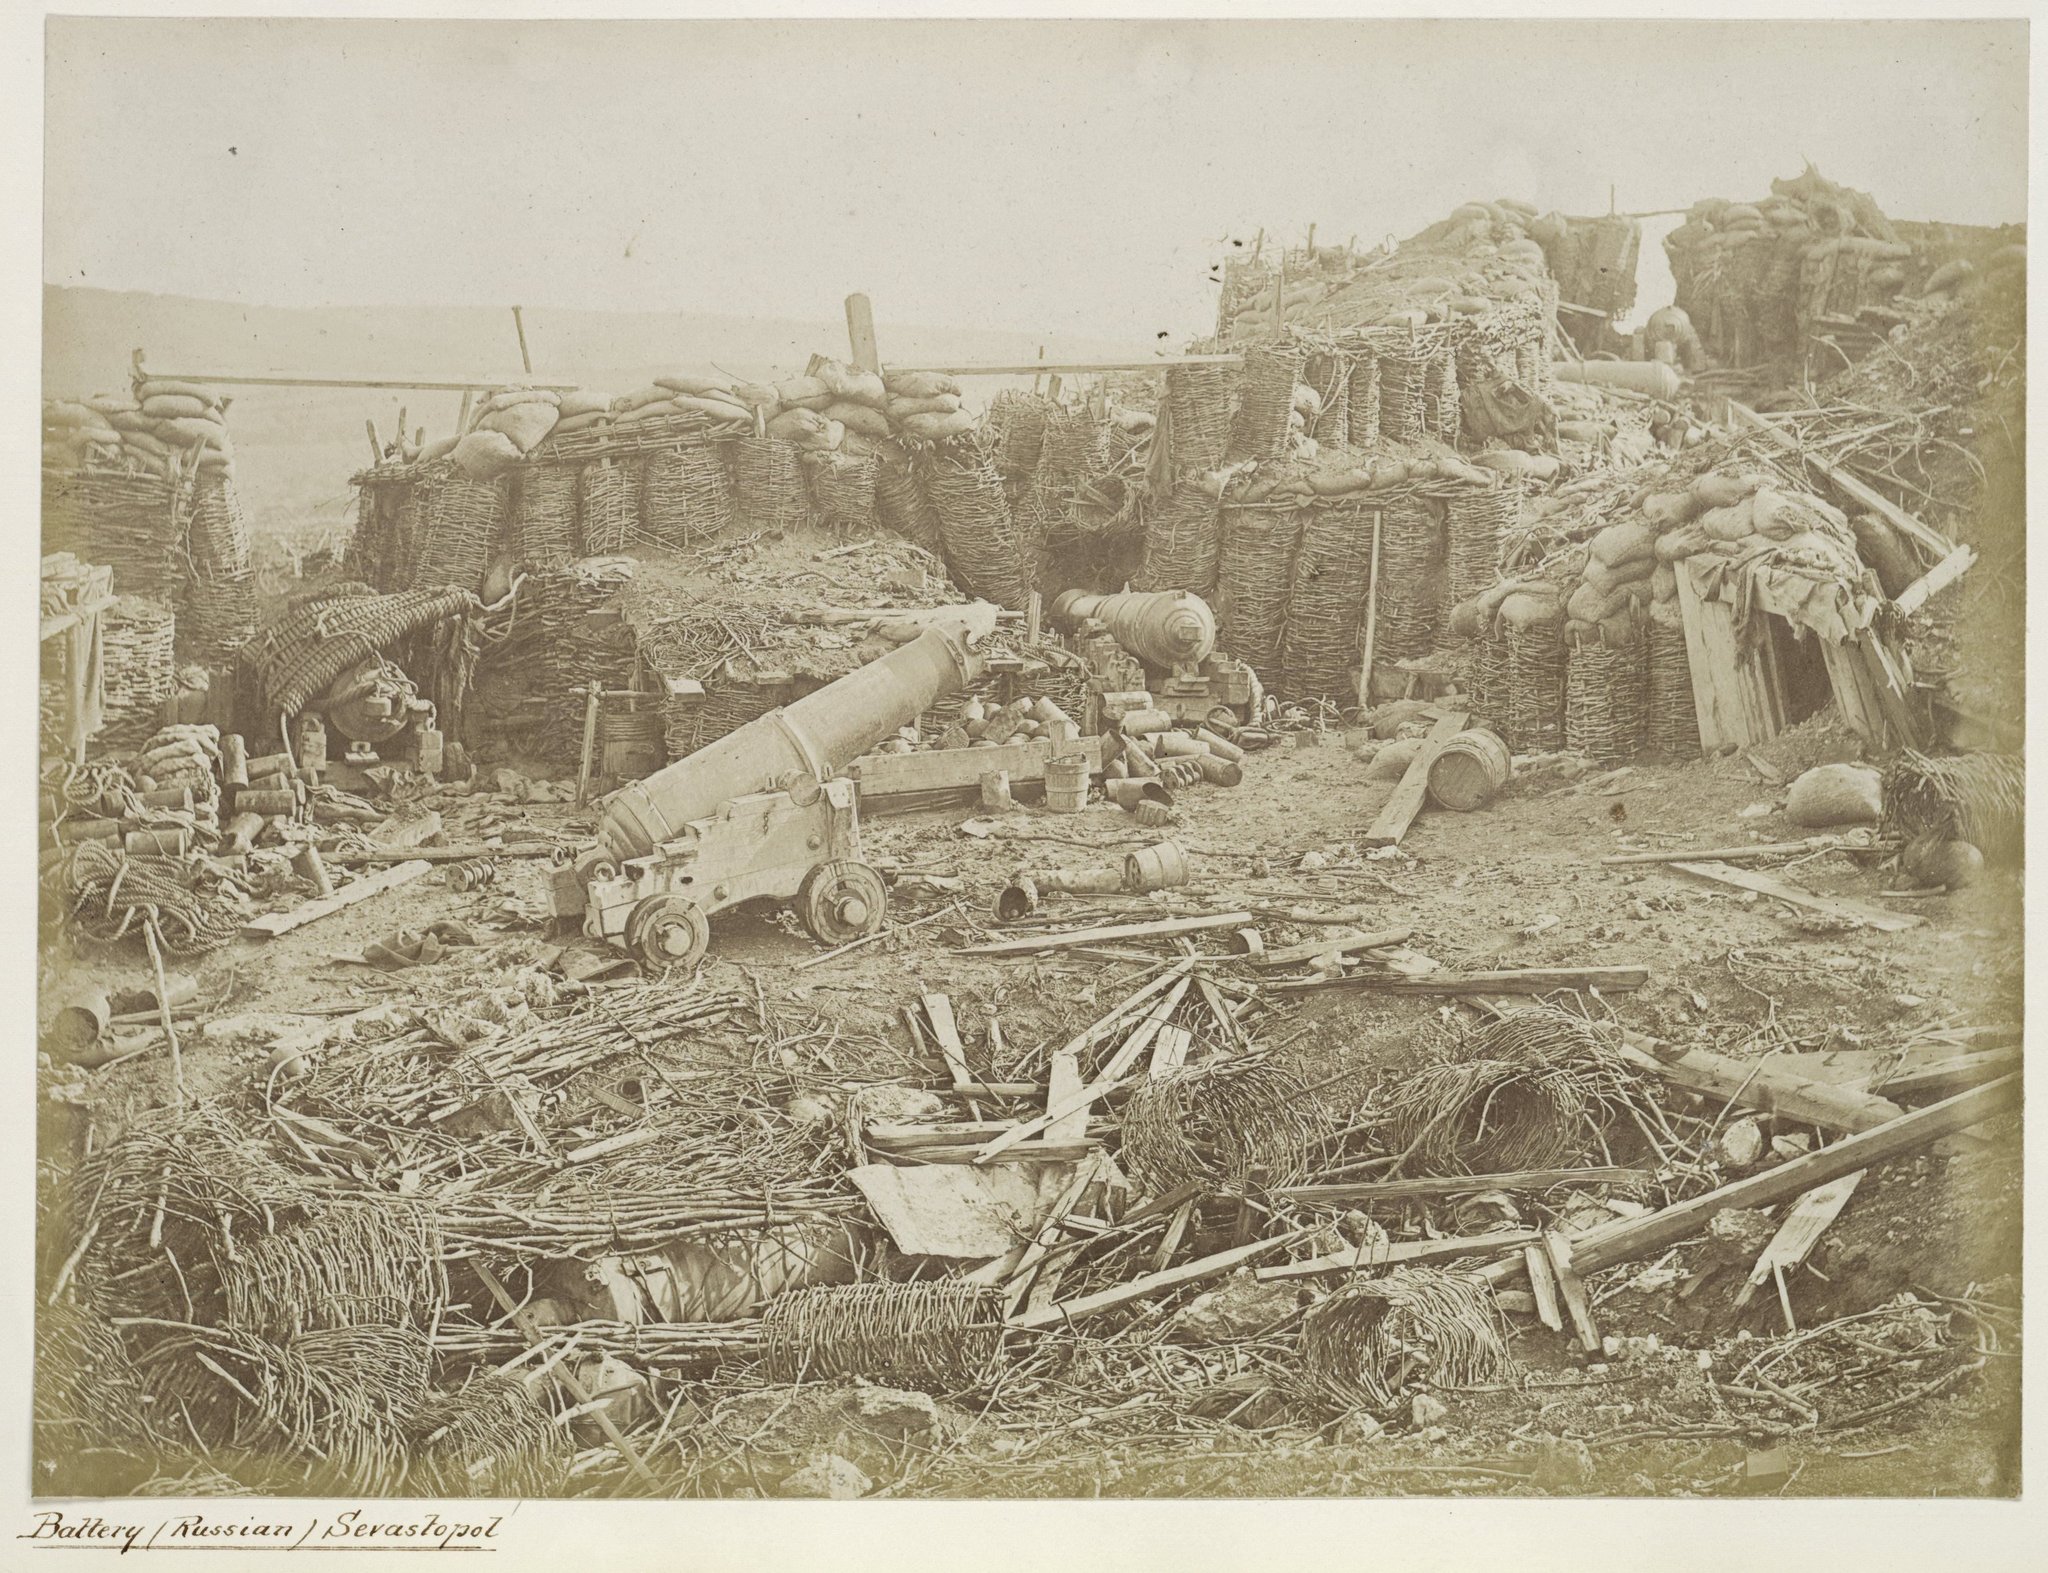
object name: photograph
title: Battery (Russian) Sevastopol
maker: james robertson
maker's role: fotograaf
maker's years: 1813-1888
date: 1809-1855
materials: cardboard, photographic support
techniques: salted paper print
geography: sebastopol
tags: loss, damage, destruction of products